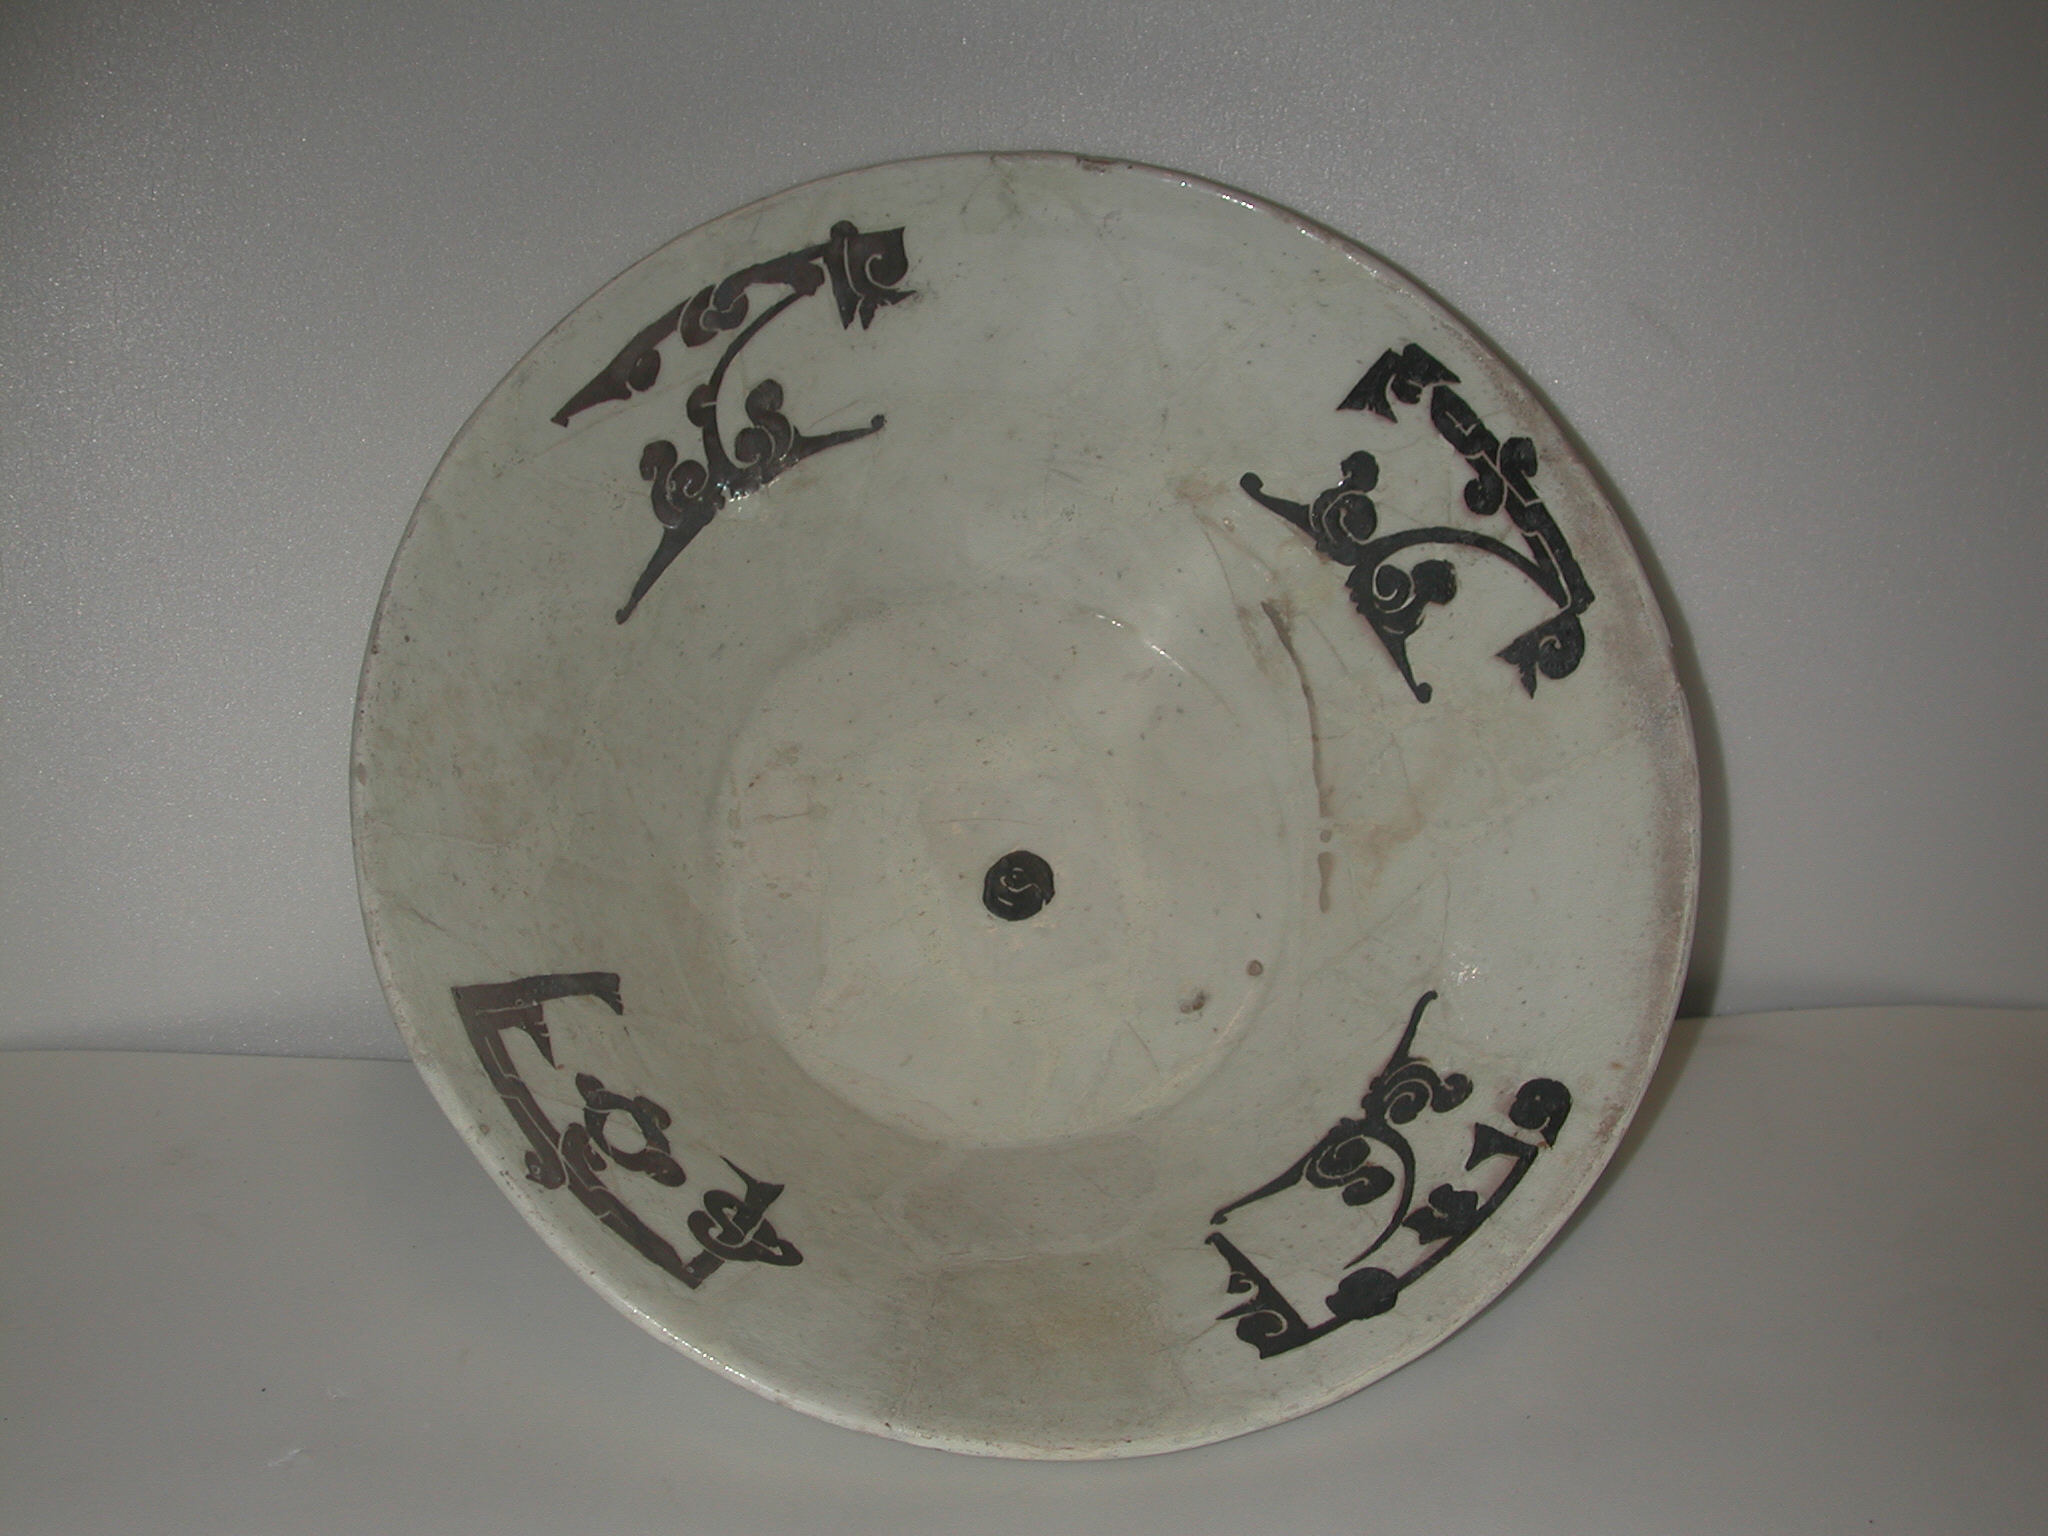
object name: bowl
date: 901-1000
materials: earthenware, glaze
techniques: incising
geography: uzbekistan